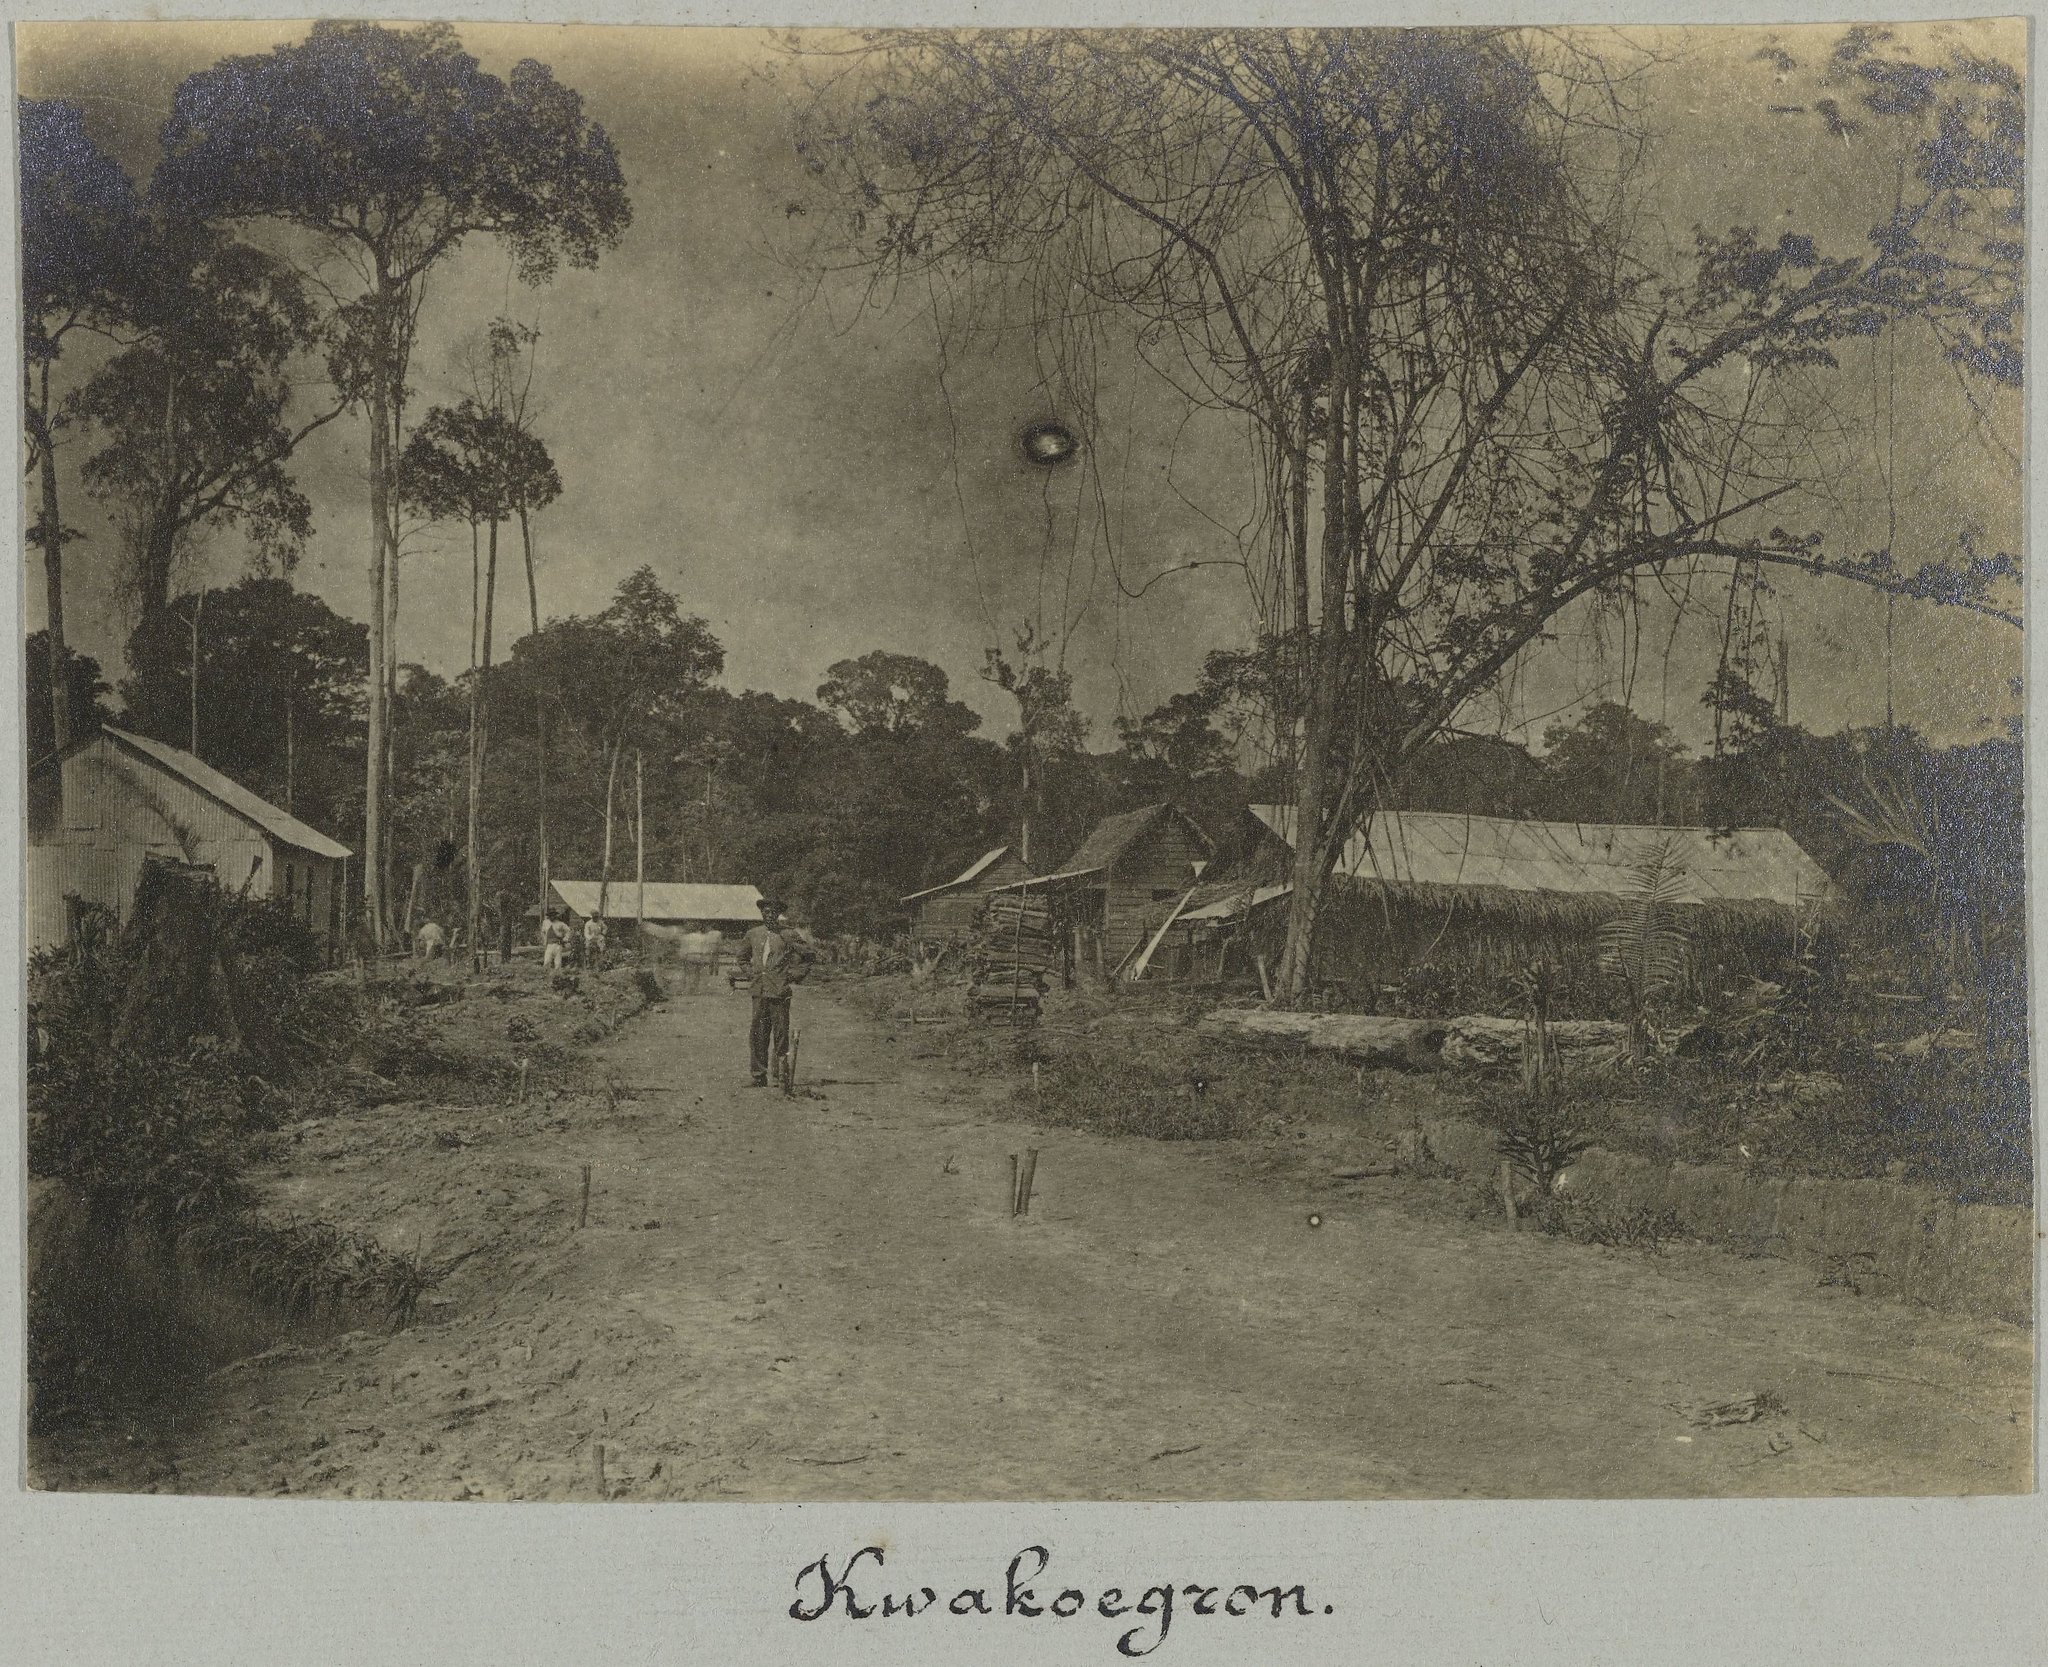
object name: photograph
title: Kwakoegron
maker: hendrik doijer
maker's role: engineer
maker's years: 1863-1925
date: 1903-1910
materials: photographic support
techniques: gelatin silver print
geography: suriname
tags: suriname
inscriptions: inscription: ‘6. / Kwakoegron’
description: Gezicht in het dorp Kwakoegron. Onderdeel van het fotoalbum Souvenir de Voyage (deel 1), over het leven van de familie Doijer in en rond de plantage Ma Retraite in Suriname in de jaren 1903-1910.